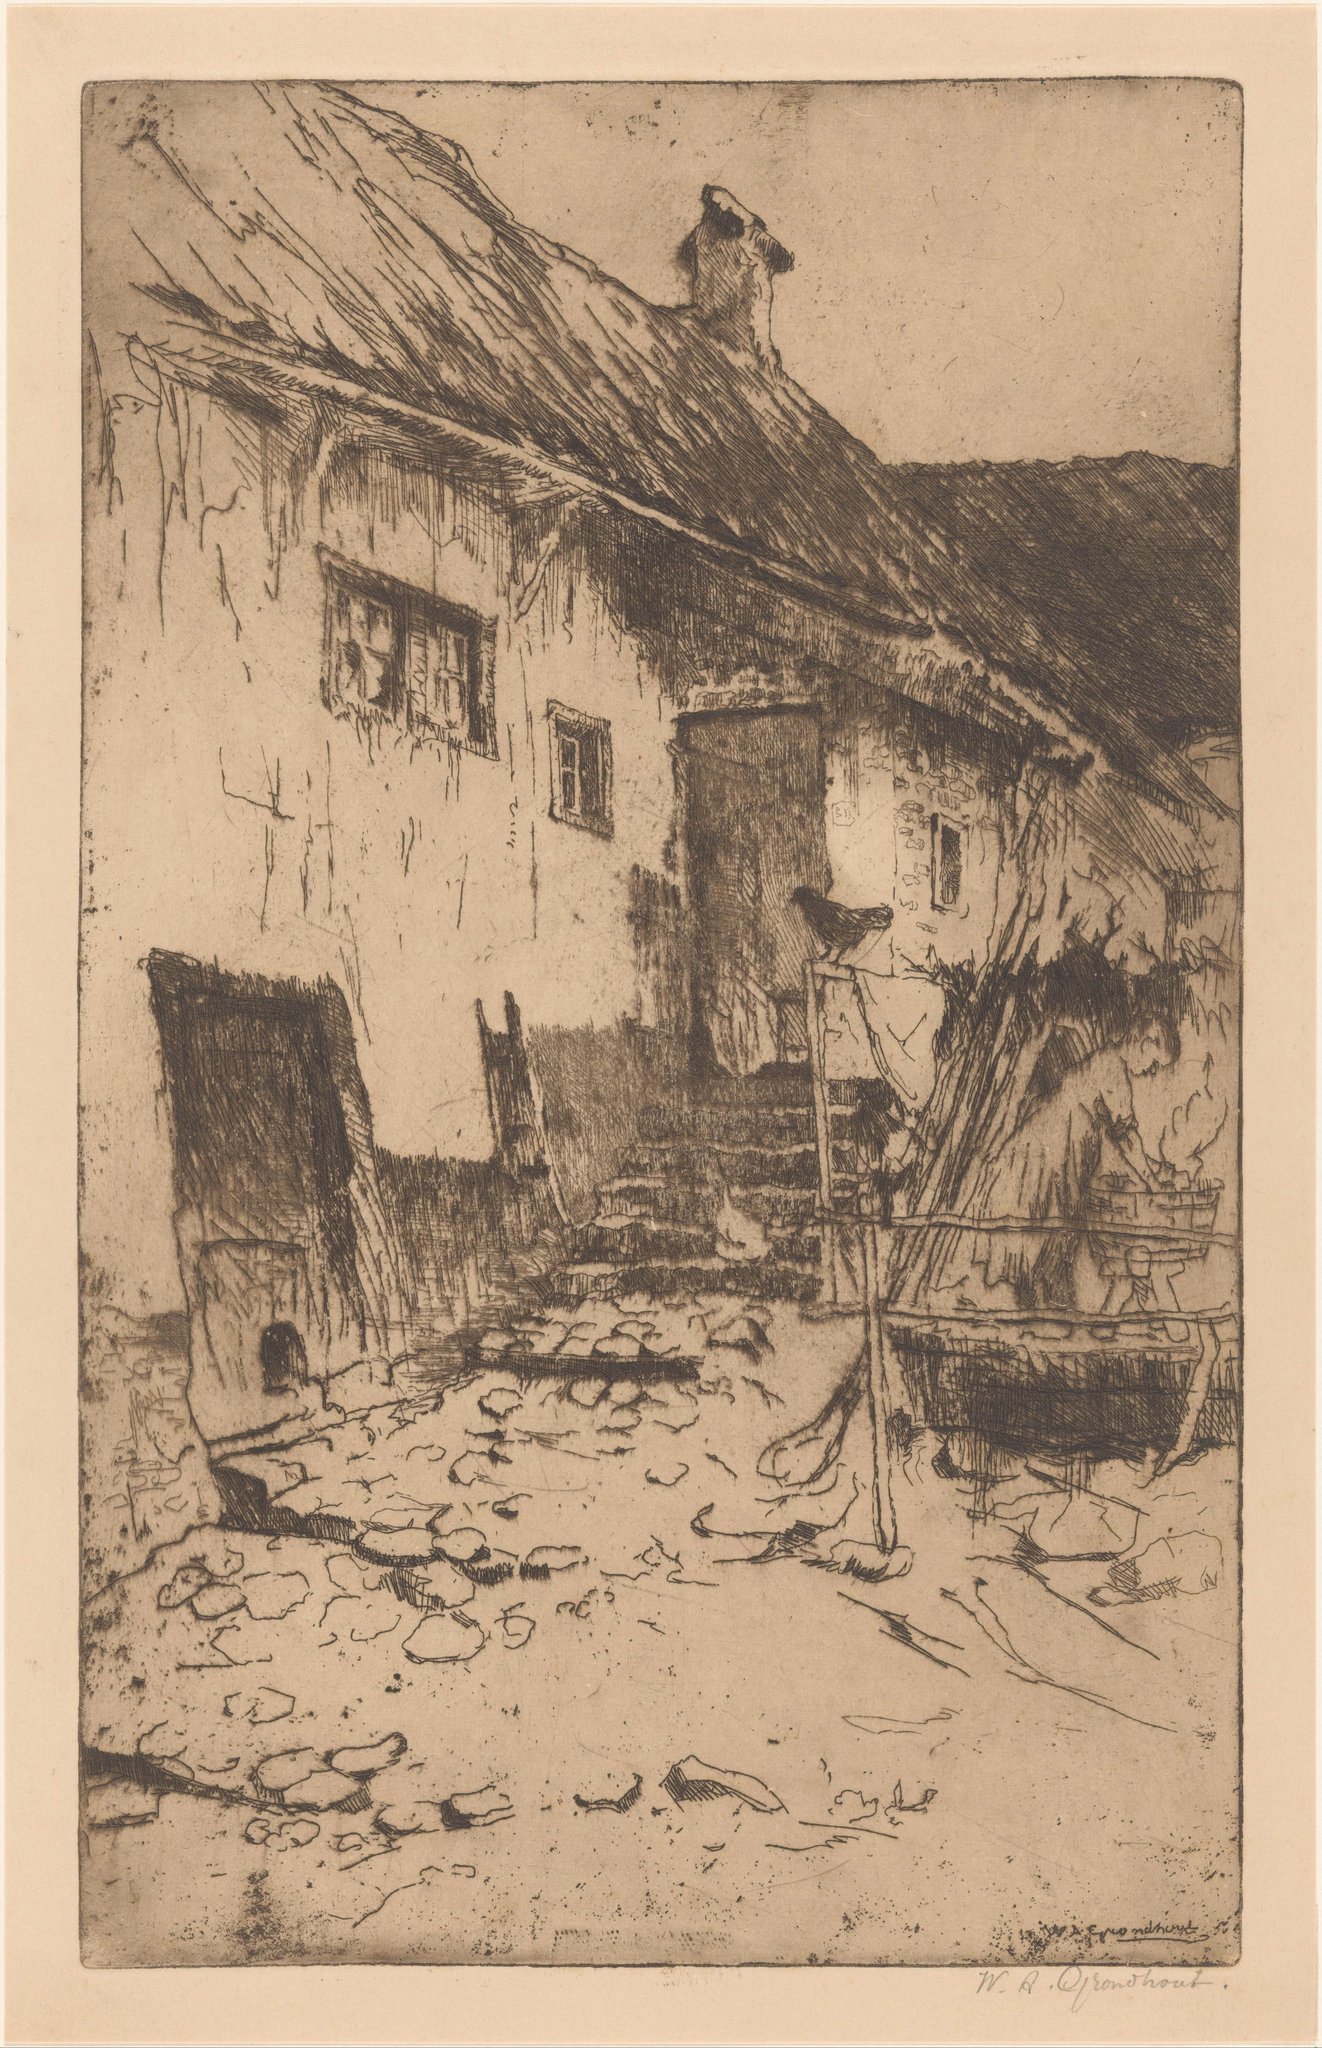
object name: print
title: Boerderij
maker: willem adrianus grondhout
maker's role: draughtsman, painter, print maker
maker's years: 1878-1934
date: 1888-1931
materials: paper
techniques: etching, intaglio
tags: laundering, farm or solitary house in landscape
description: Naast het huis gebruikt een vrouw een wastobbe.